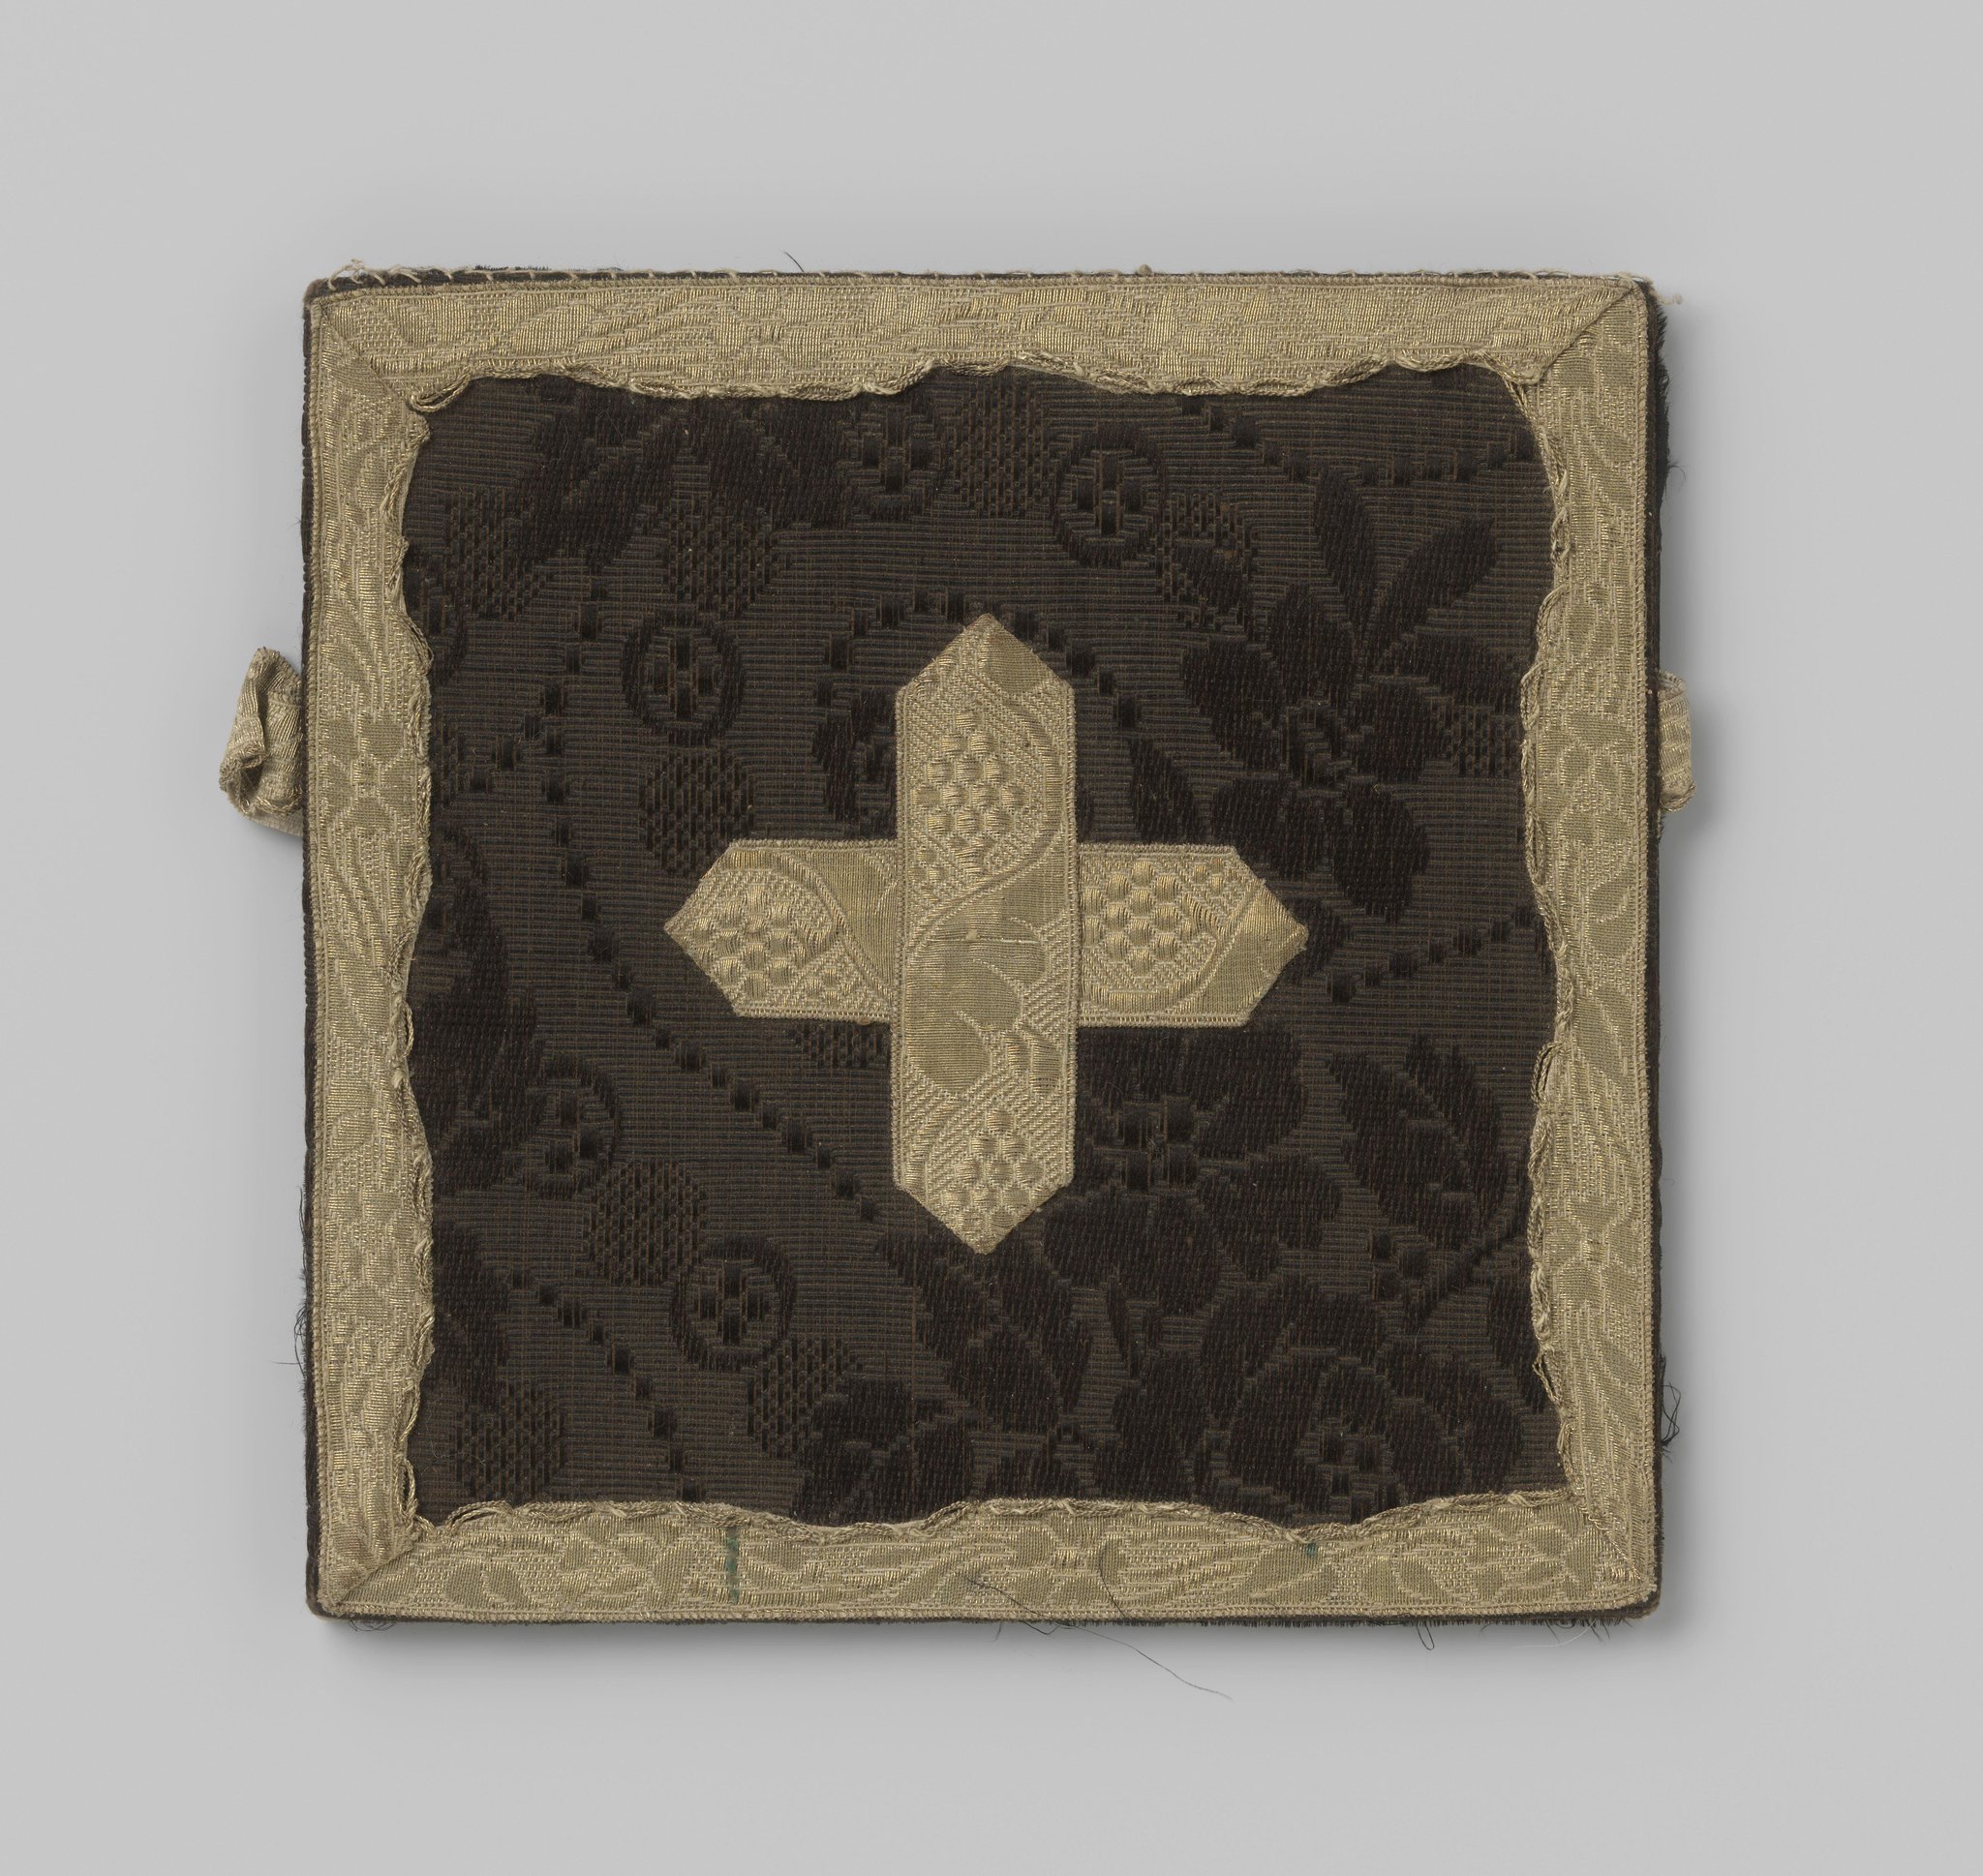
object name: liturgical object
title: Beurs met borduurwerk.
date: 1800-1900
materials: textile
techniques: brocade, embroidered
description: Beurs met borduurwerk flora en fauna. In het midden een versierd Andreaskruis.